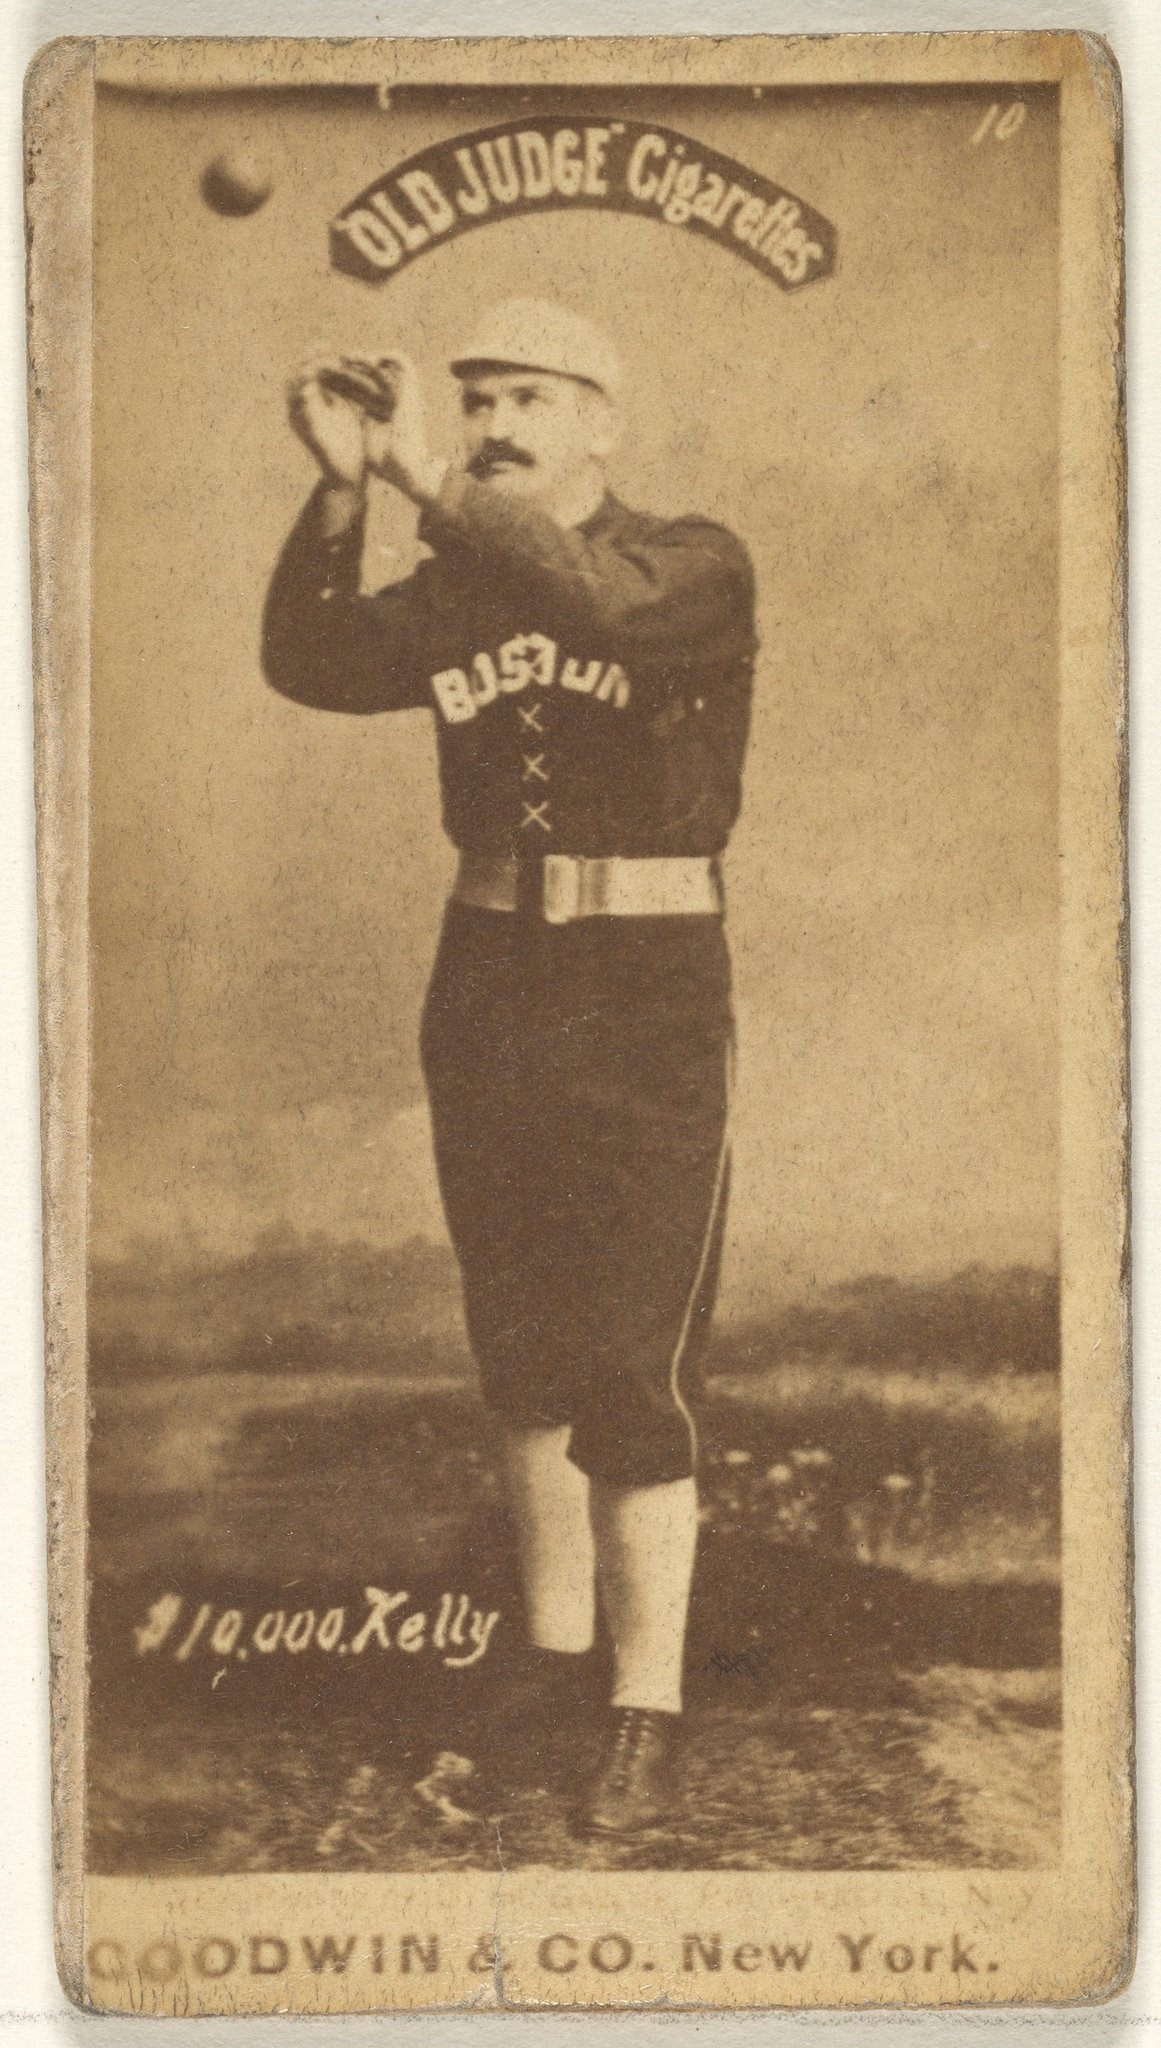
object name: baseball card, photograph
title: "$10,000" Kelly, Boston, from the Old Judge series (N172) for Old Judge Cigarettes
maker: goodwin & company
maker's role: publisher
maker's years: 1850-1950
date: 1887-1890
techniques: albumen silver print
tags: men,portraits,baseball,athletes